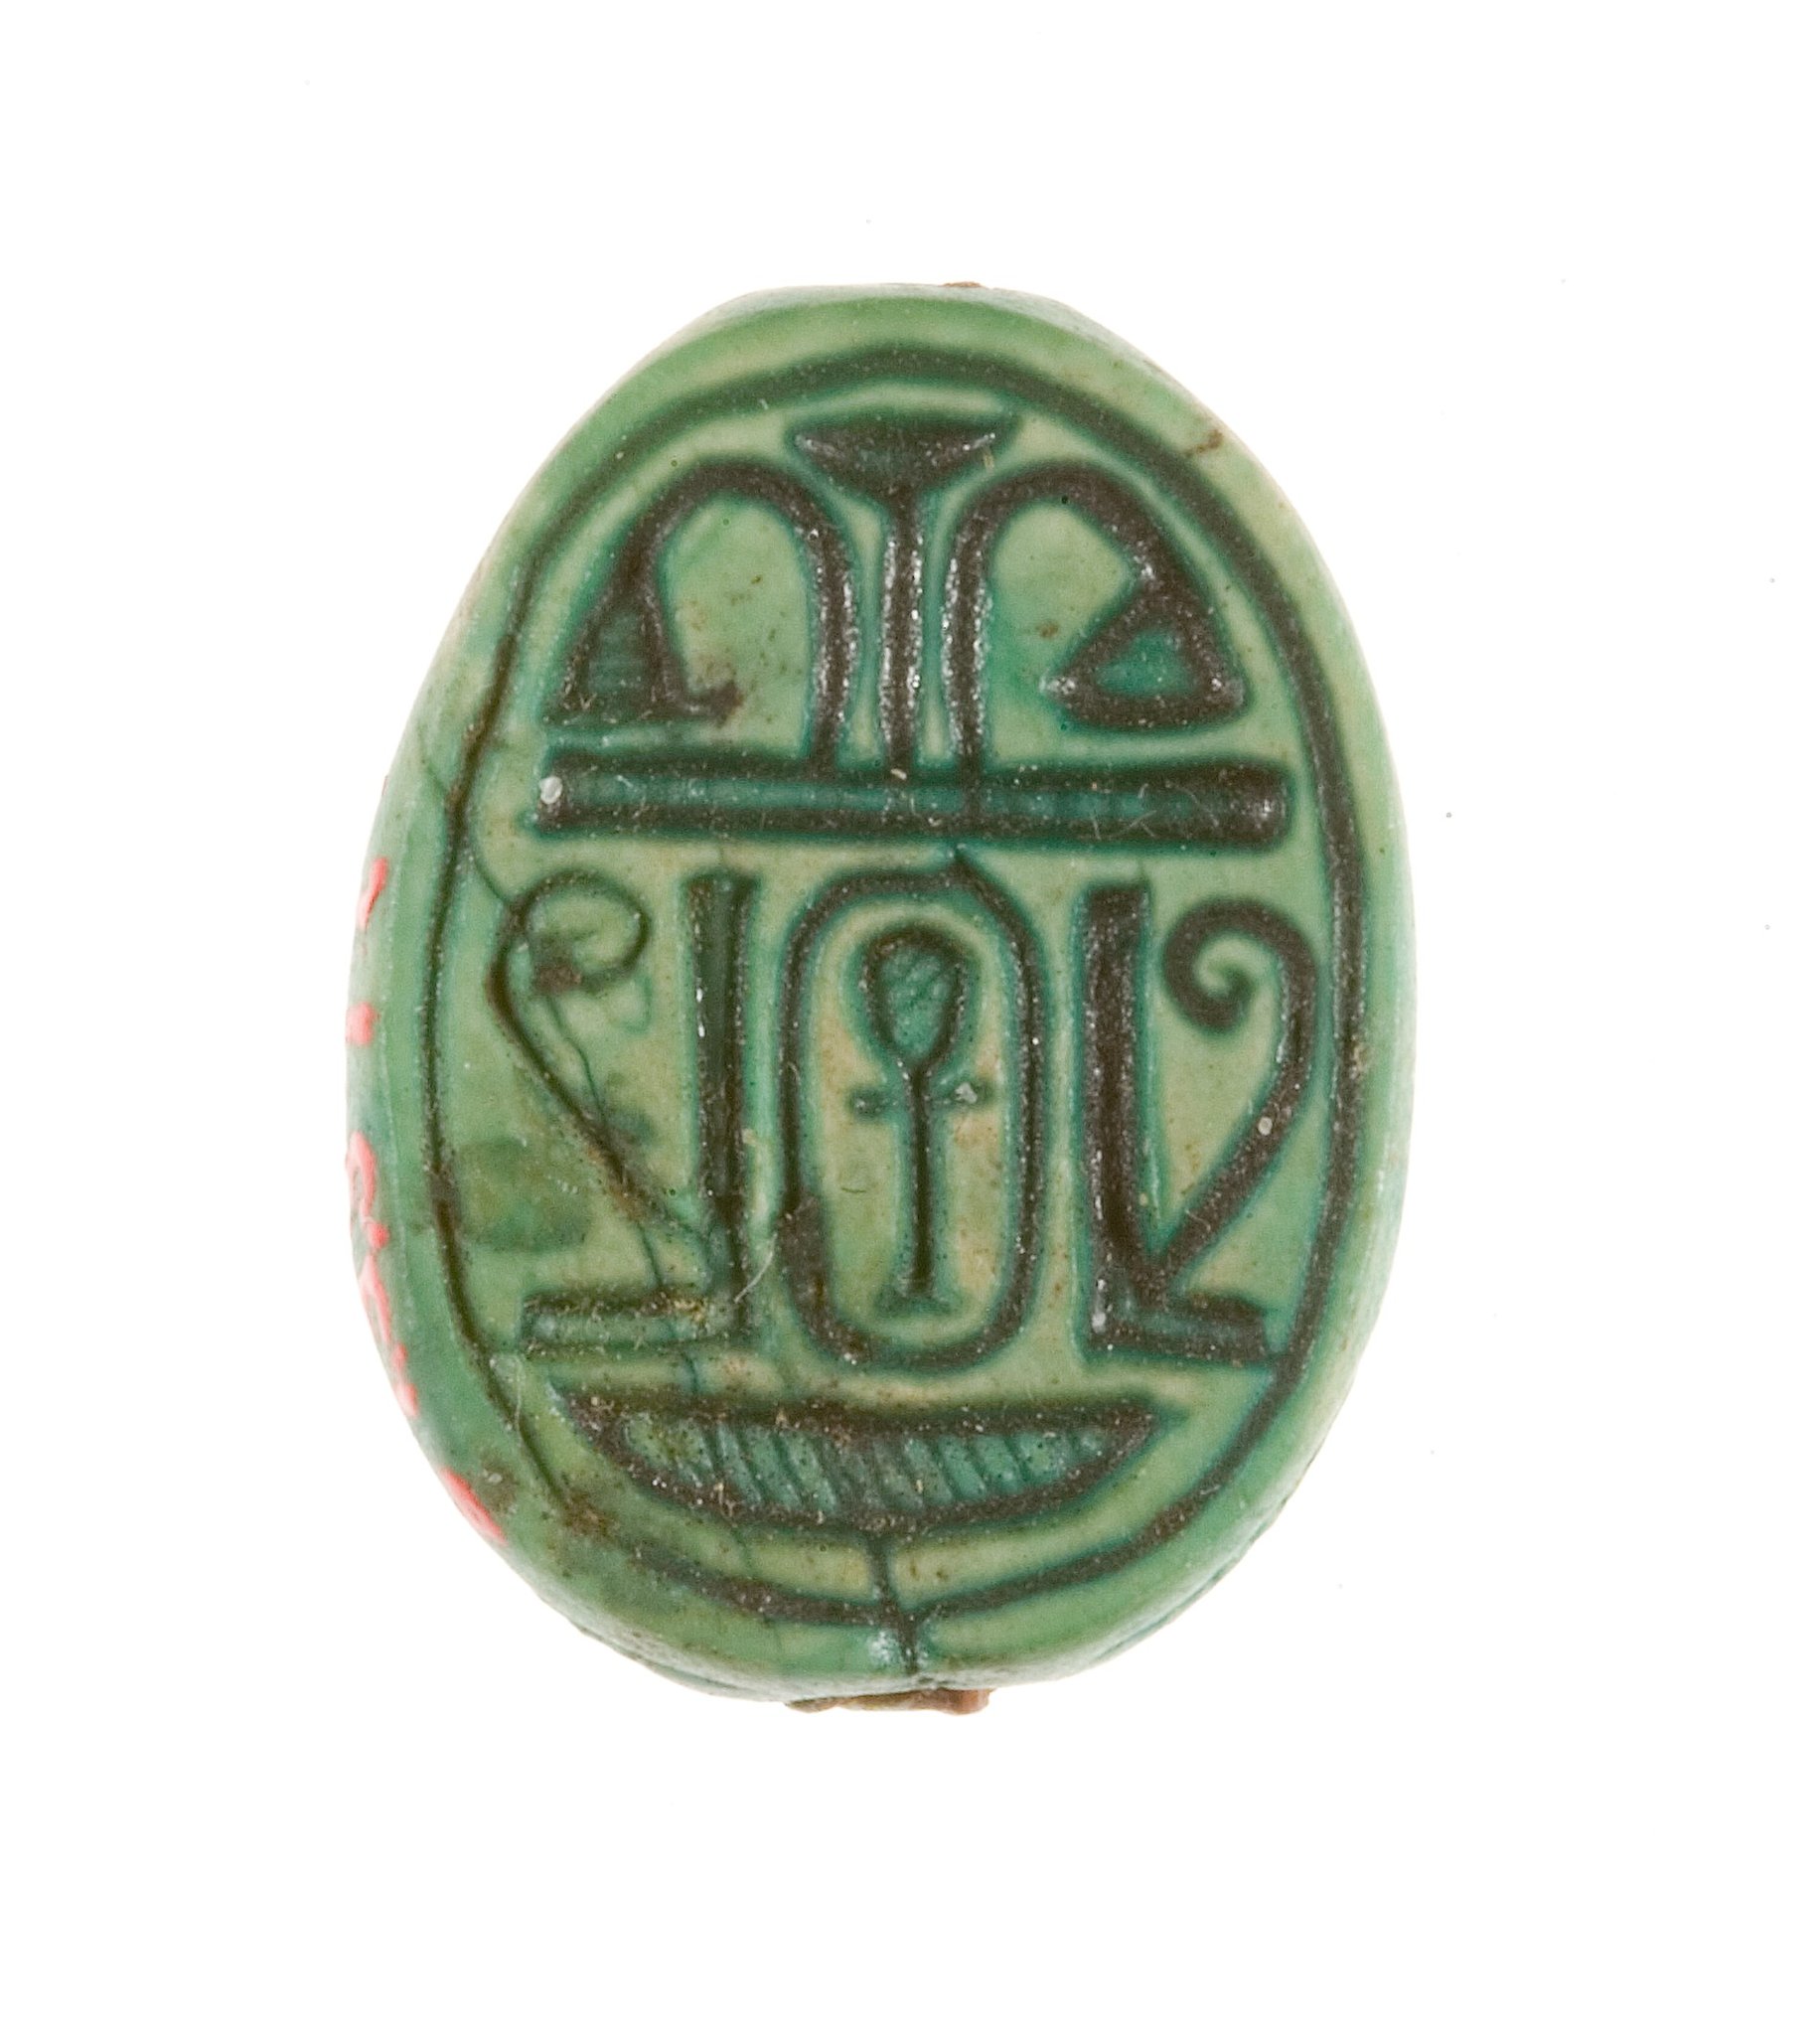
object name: scarab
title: Scarab Inscribed with a Decorative Motif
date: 1479-1458 BCE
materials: stone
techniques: glazing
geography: egypt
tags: scarabs